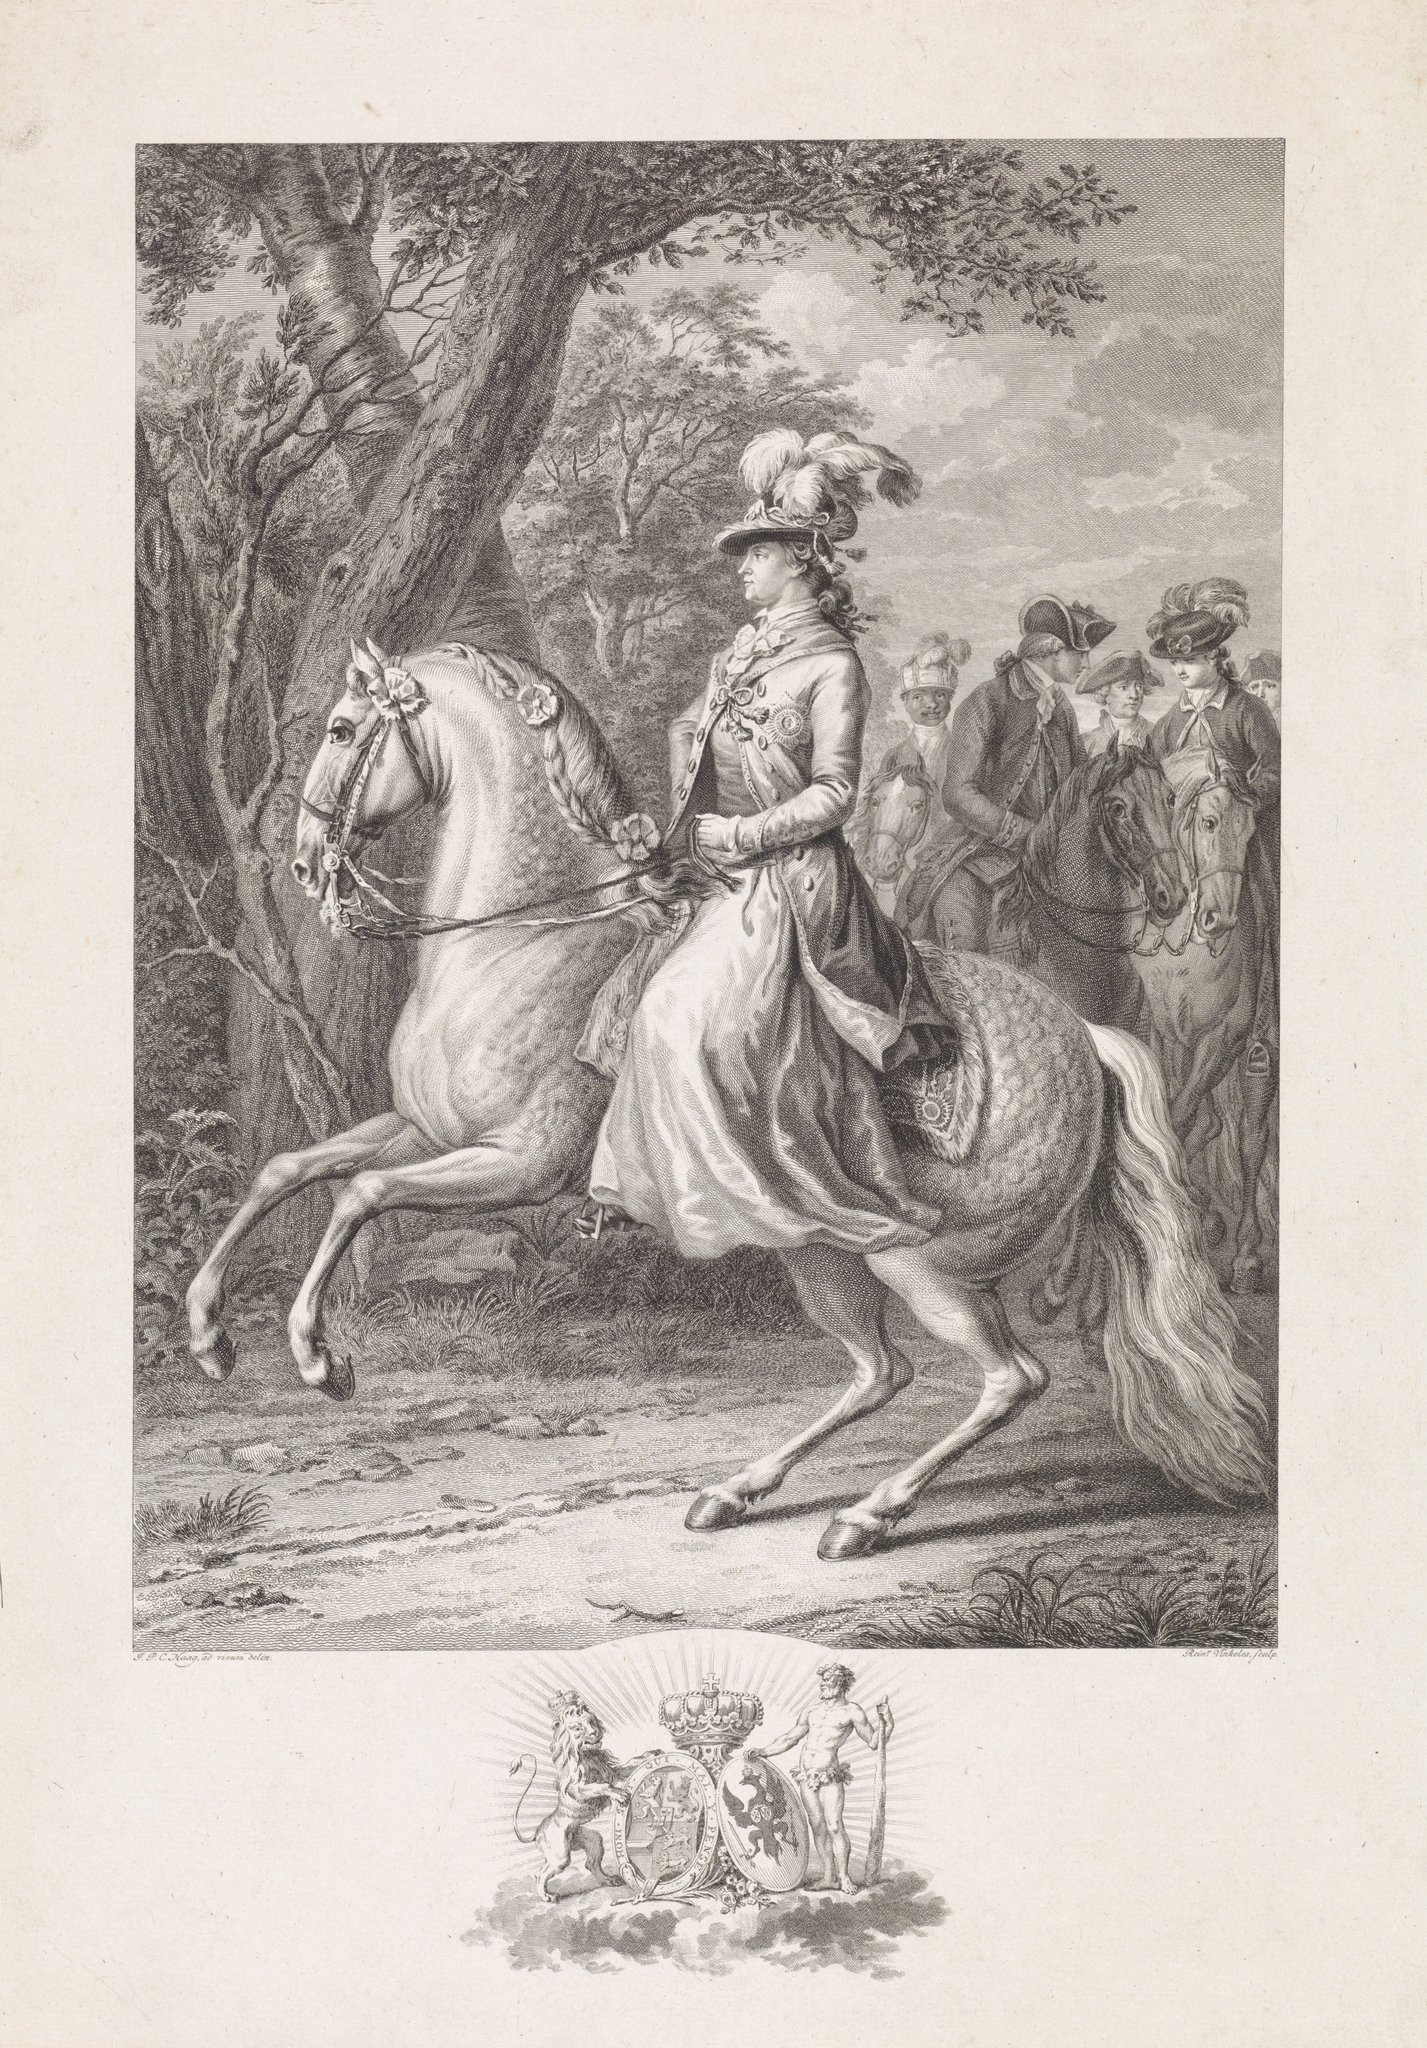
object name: print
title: Portret van Wilhelmina van Pruisen, te paard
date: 1779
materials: paper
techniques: engraving, etching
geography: amsterdam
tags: berlin, draughtsman, wilhelmina of prussia (princess of orange), horse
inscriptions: collector's mark: Lugt 2228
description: Portret van Wilhelmina van Pruisen, te paard in een landschap. Achter haar haar gevolg. Onderaan het wapen